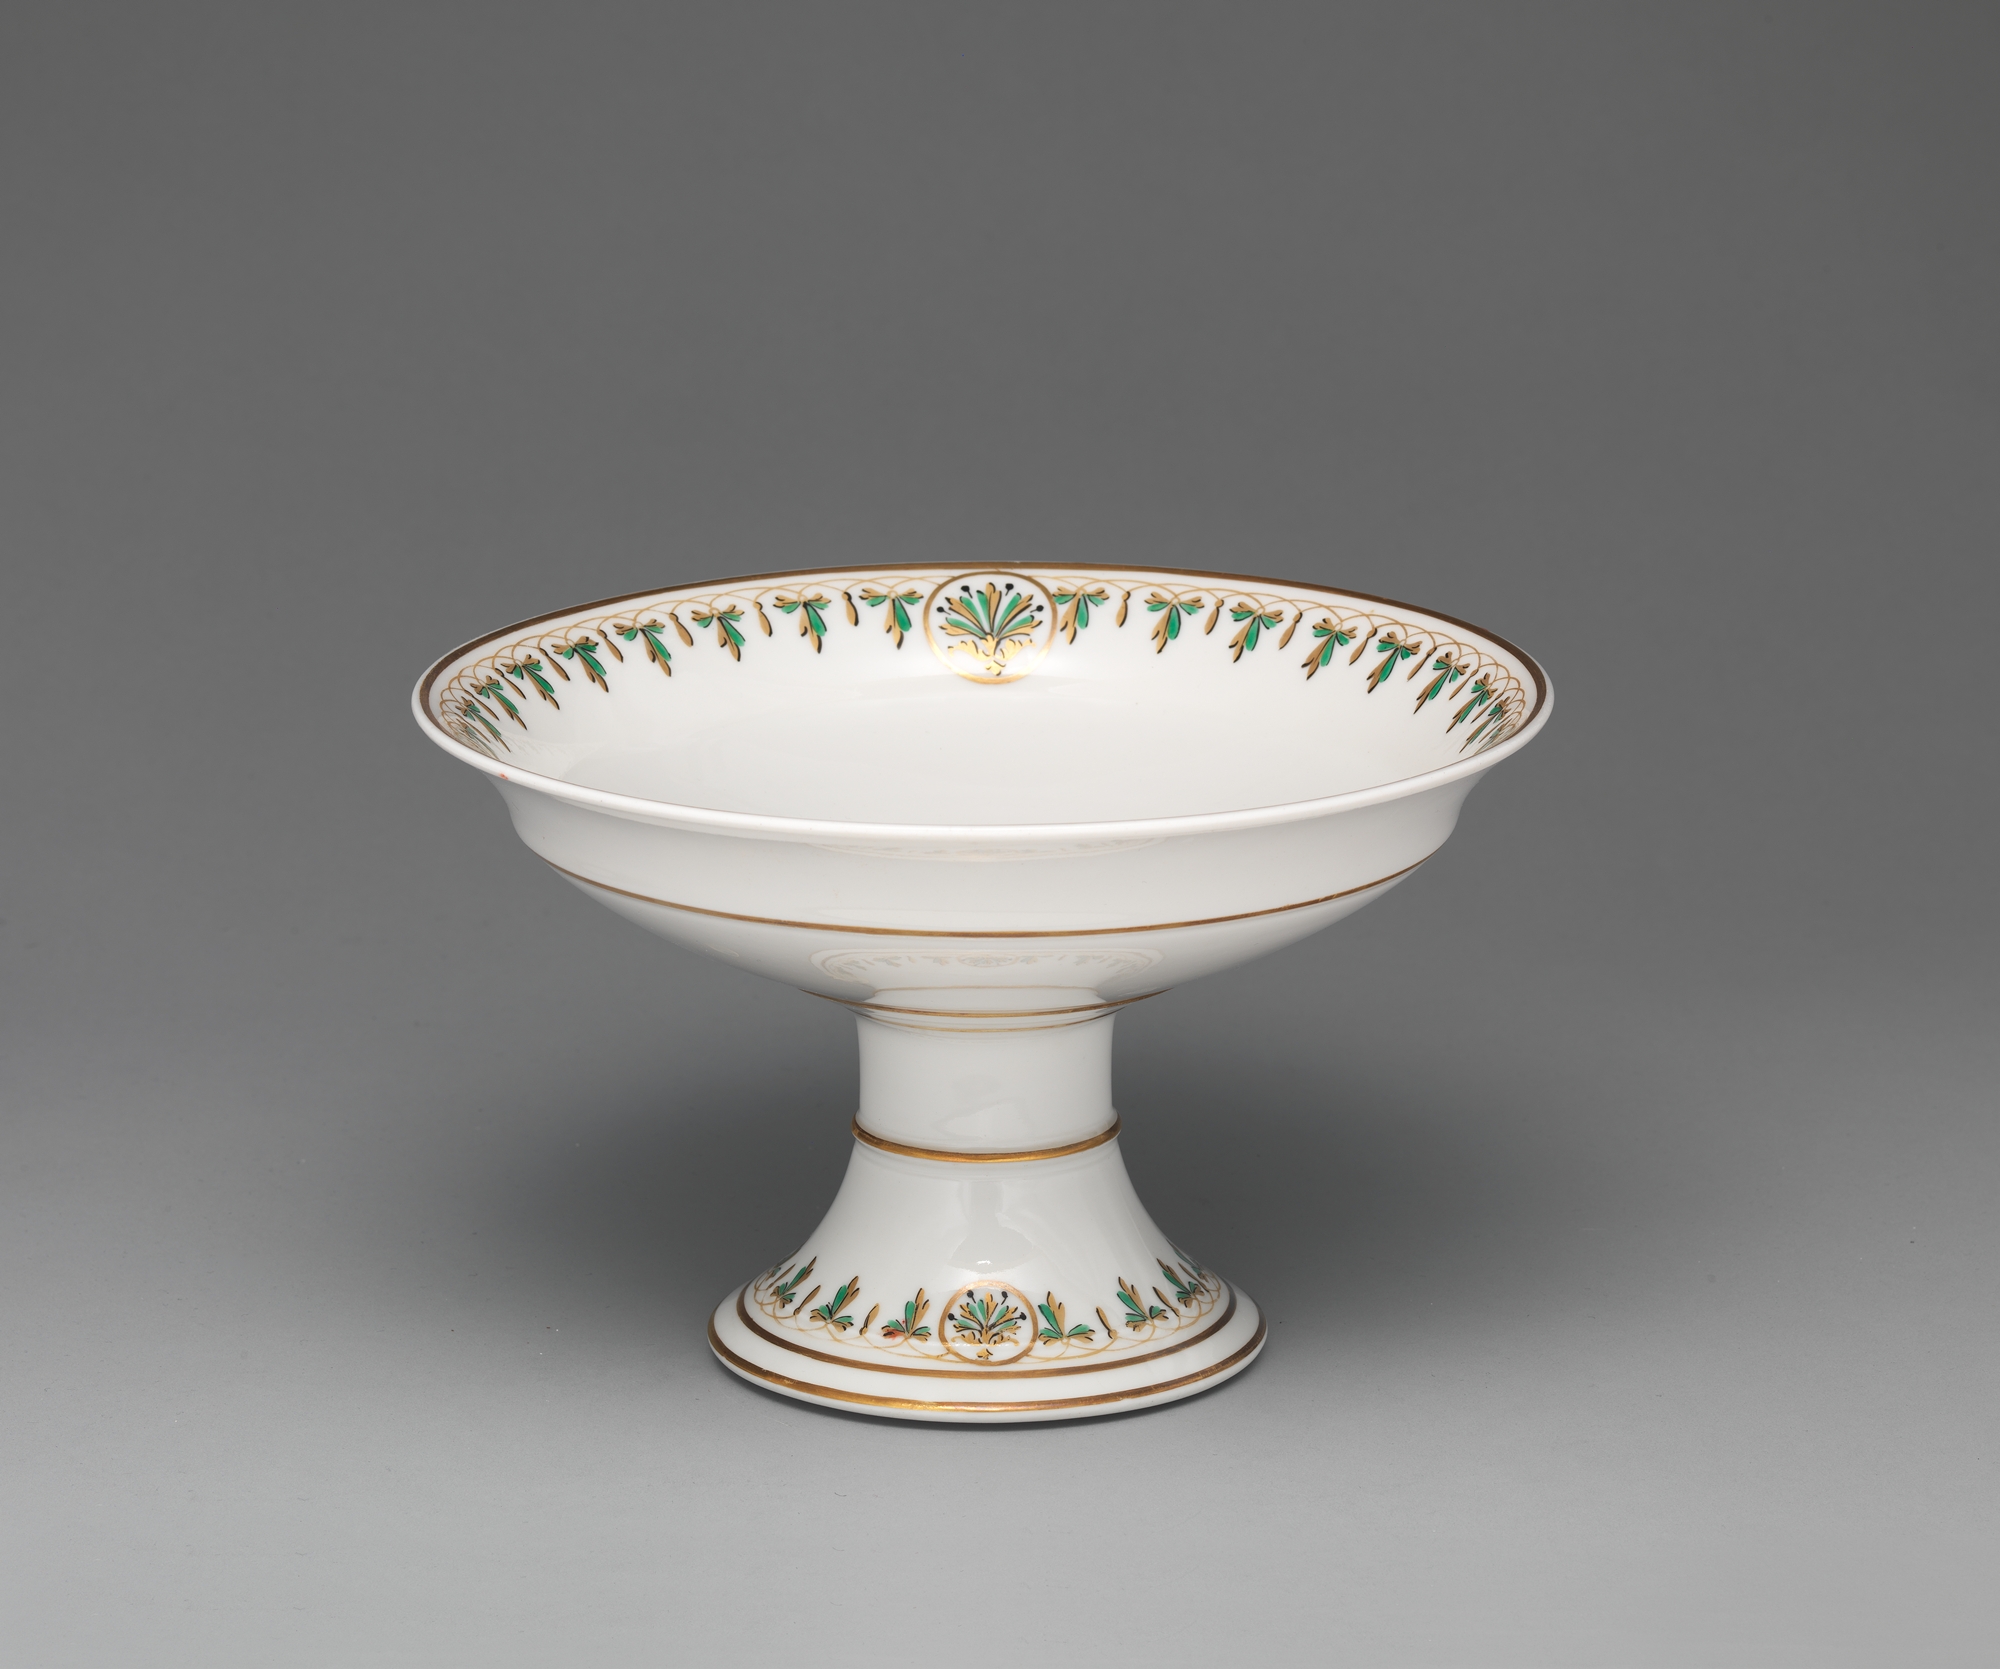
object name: compote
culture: american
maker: union porcelain works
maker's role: maker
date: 1885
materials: porcelain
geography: united states